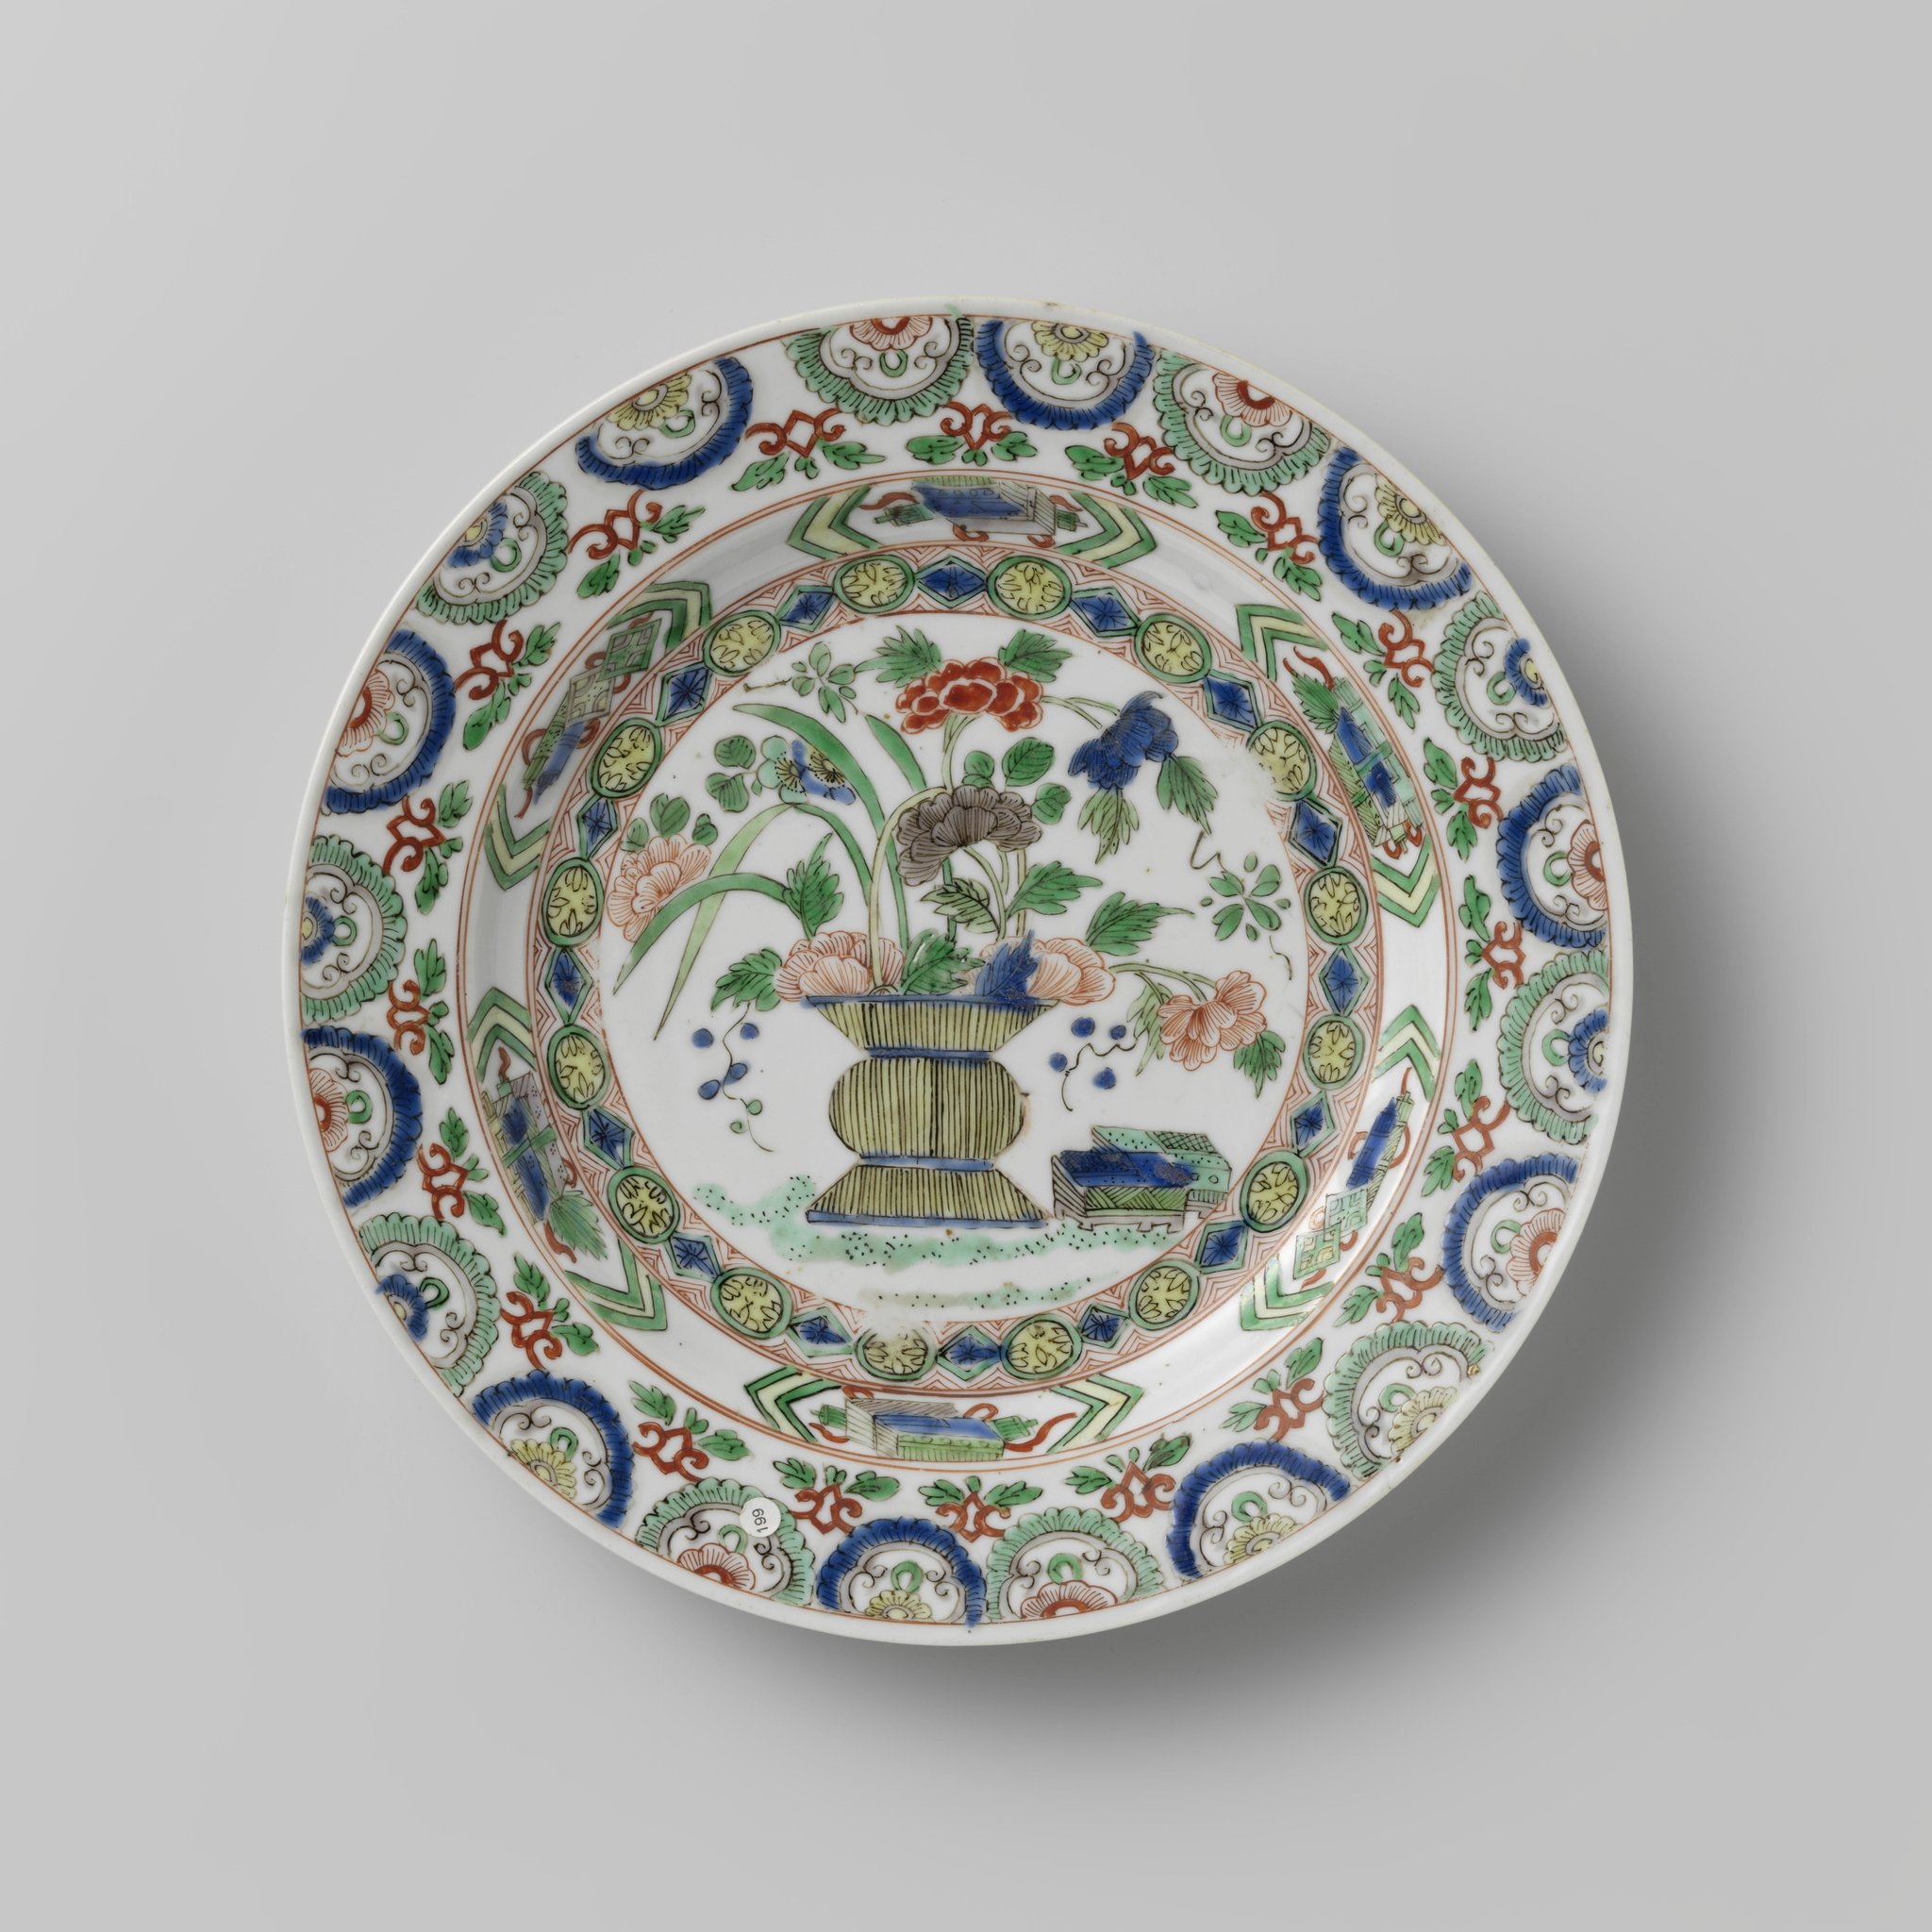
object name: plate dish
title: Plate with a flower basket and precious objects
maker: Anonymous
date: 1675-1699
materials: cobalt, glaze, paint, porcelain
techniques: firing, turning, vitrification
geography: china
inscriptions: label: ‘May’, mark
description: Bord, famille verte, hengselmand gevuld met bloemen omgeven door een rand.